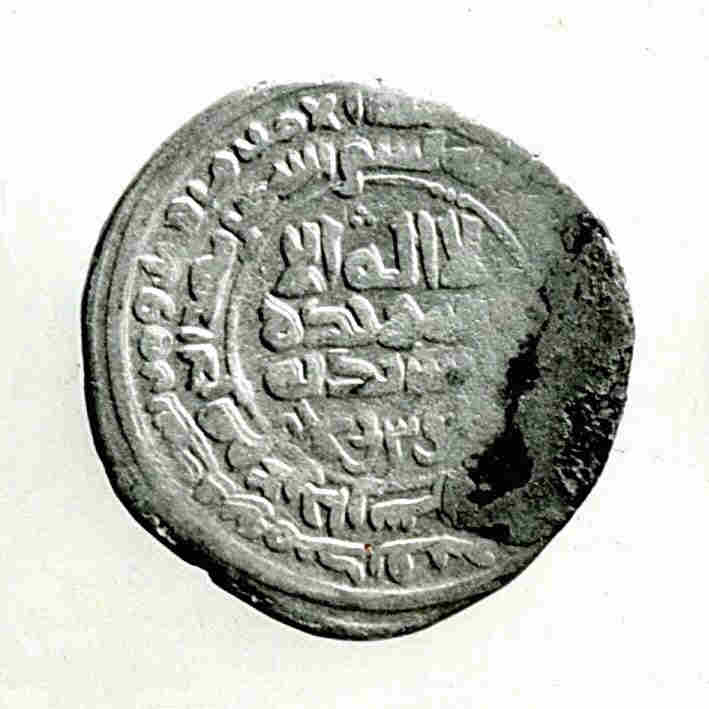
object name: coin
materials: silver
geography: iran